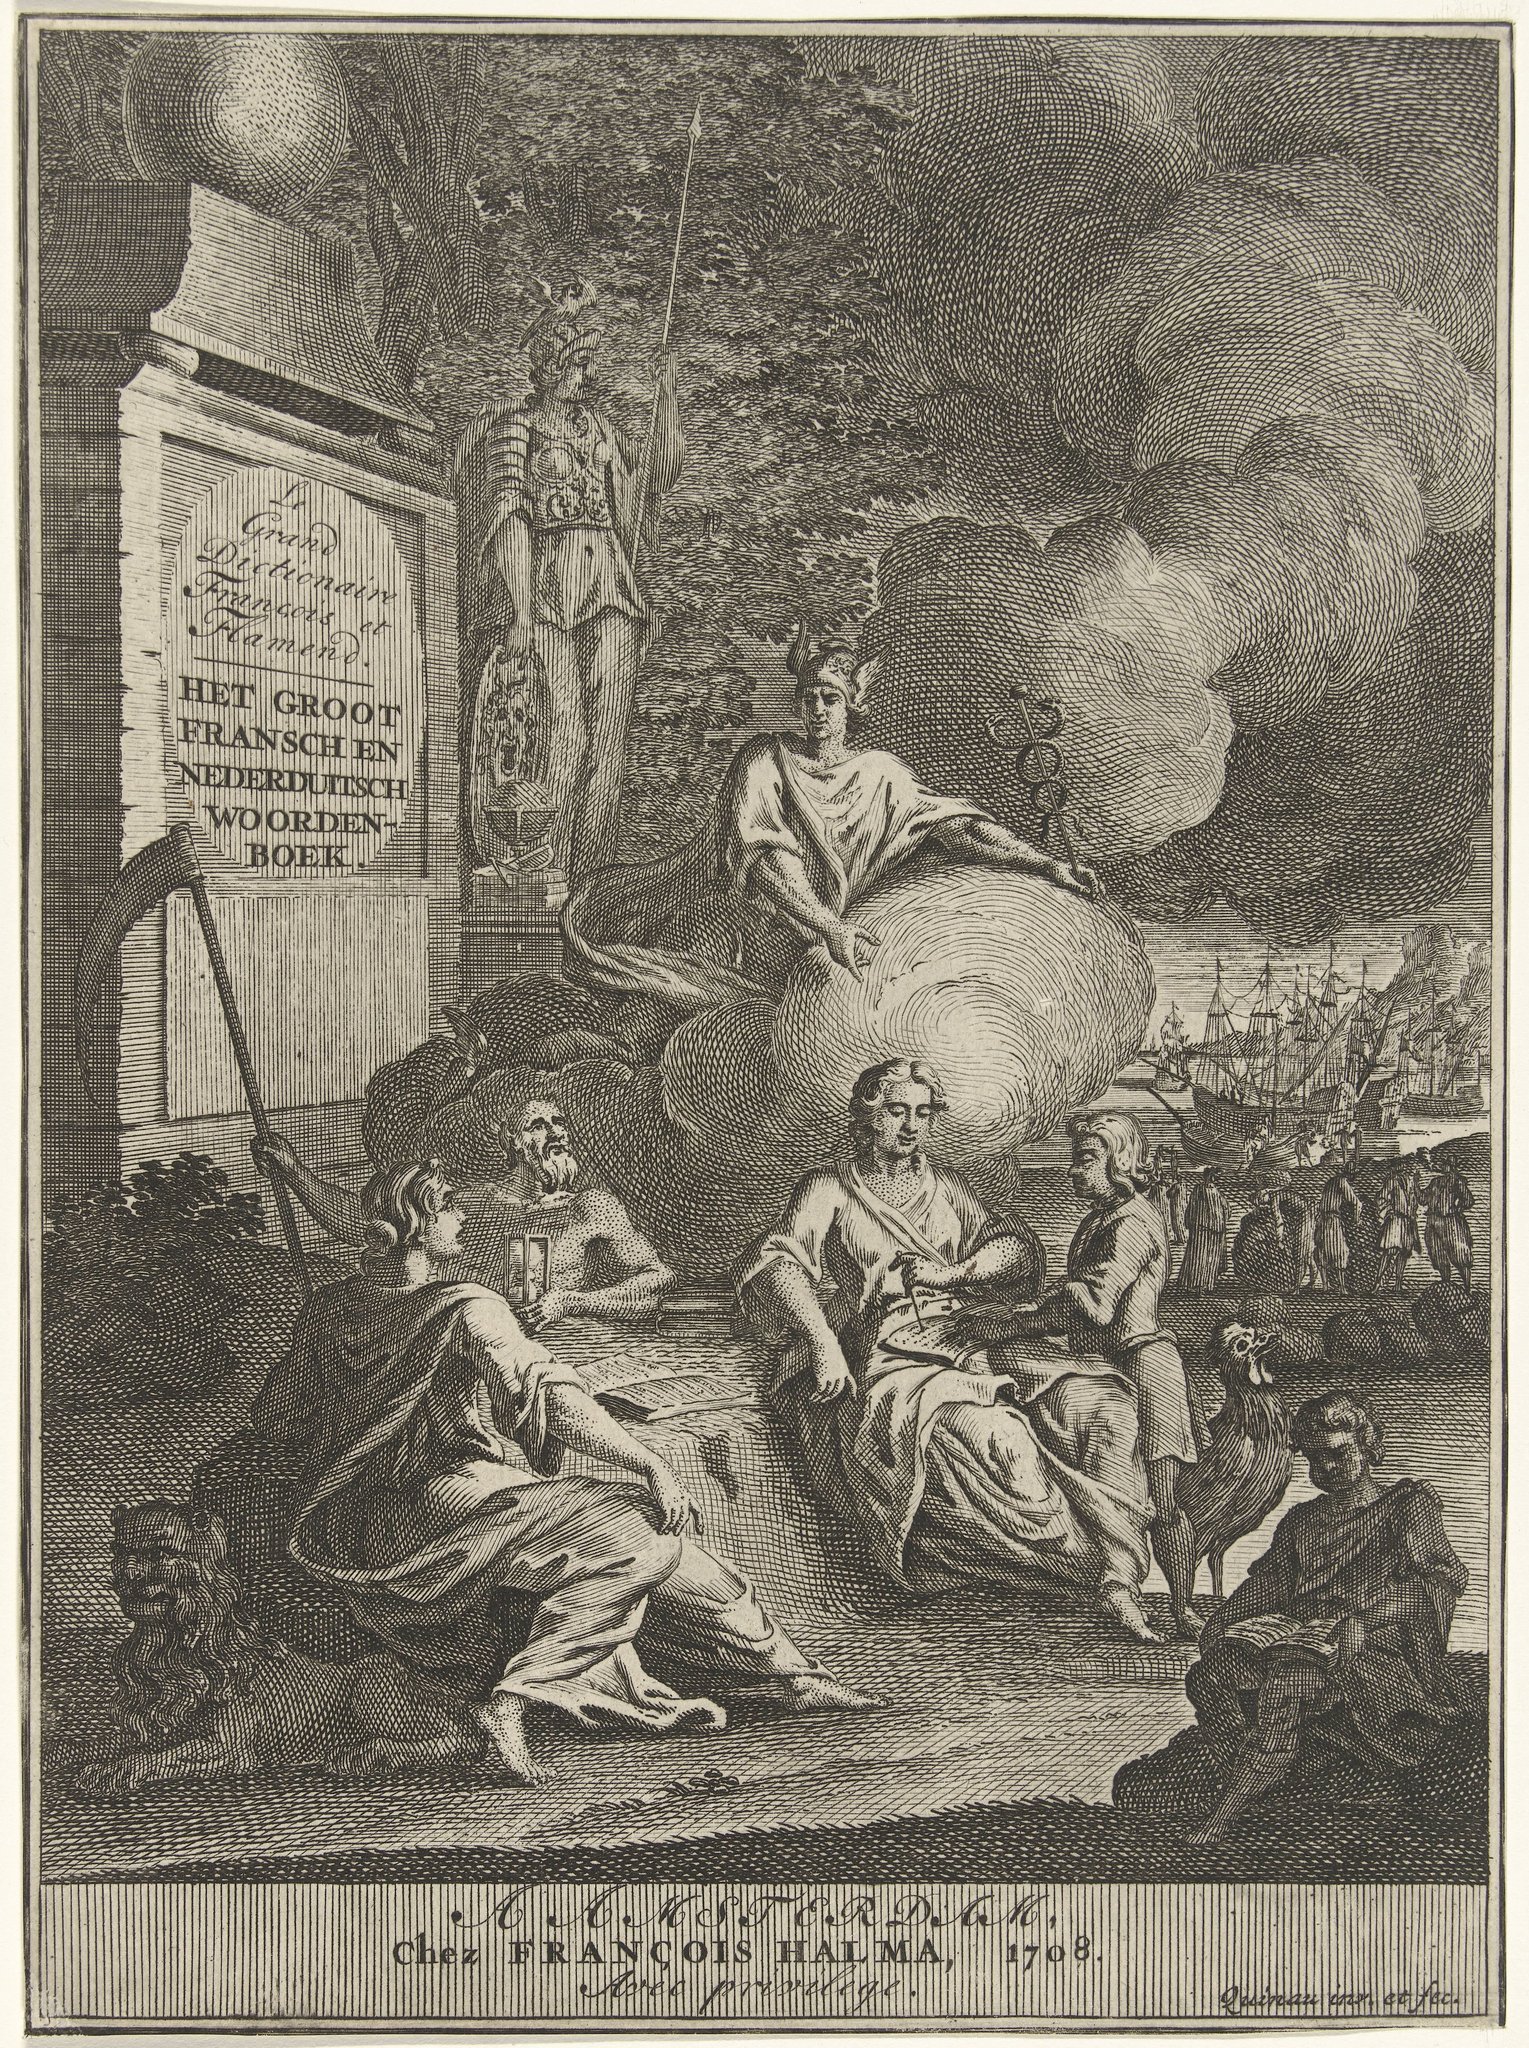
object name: print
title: Titelpagina voor 'Het Groot Fransch en Nederduitsch Woordenboek'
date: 1708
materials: paper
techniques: engraving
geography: amsterdam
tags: (story of) minerva (pallas, athena), (story of) mercury (hermes), attributes of aesculapius: cock, beasts of prey, predatory animals: lion, father time, man with wings and scythe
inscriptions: collector's mark: Lugt 2228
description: Titelpagina voor 'Het Groot Fransch en Nederduitsch Woordenboek', met de titel op een sokkel. Voor de piëdestal verschillende goden en personificaties, zoals Minerva, Mercurius, Vader Tijd, de Franse haan en de Nederlandse leeuw. Op de achtergrond een aantal zeilschepen.